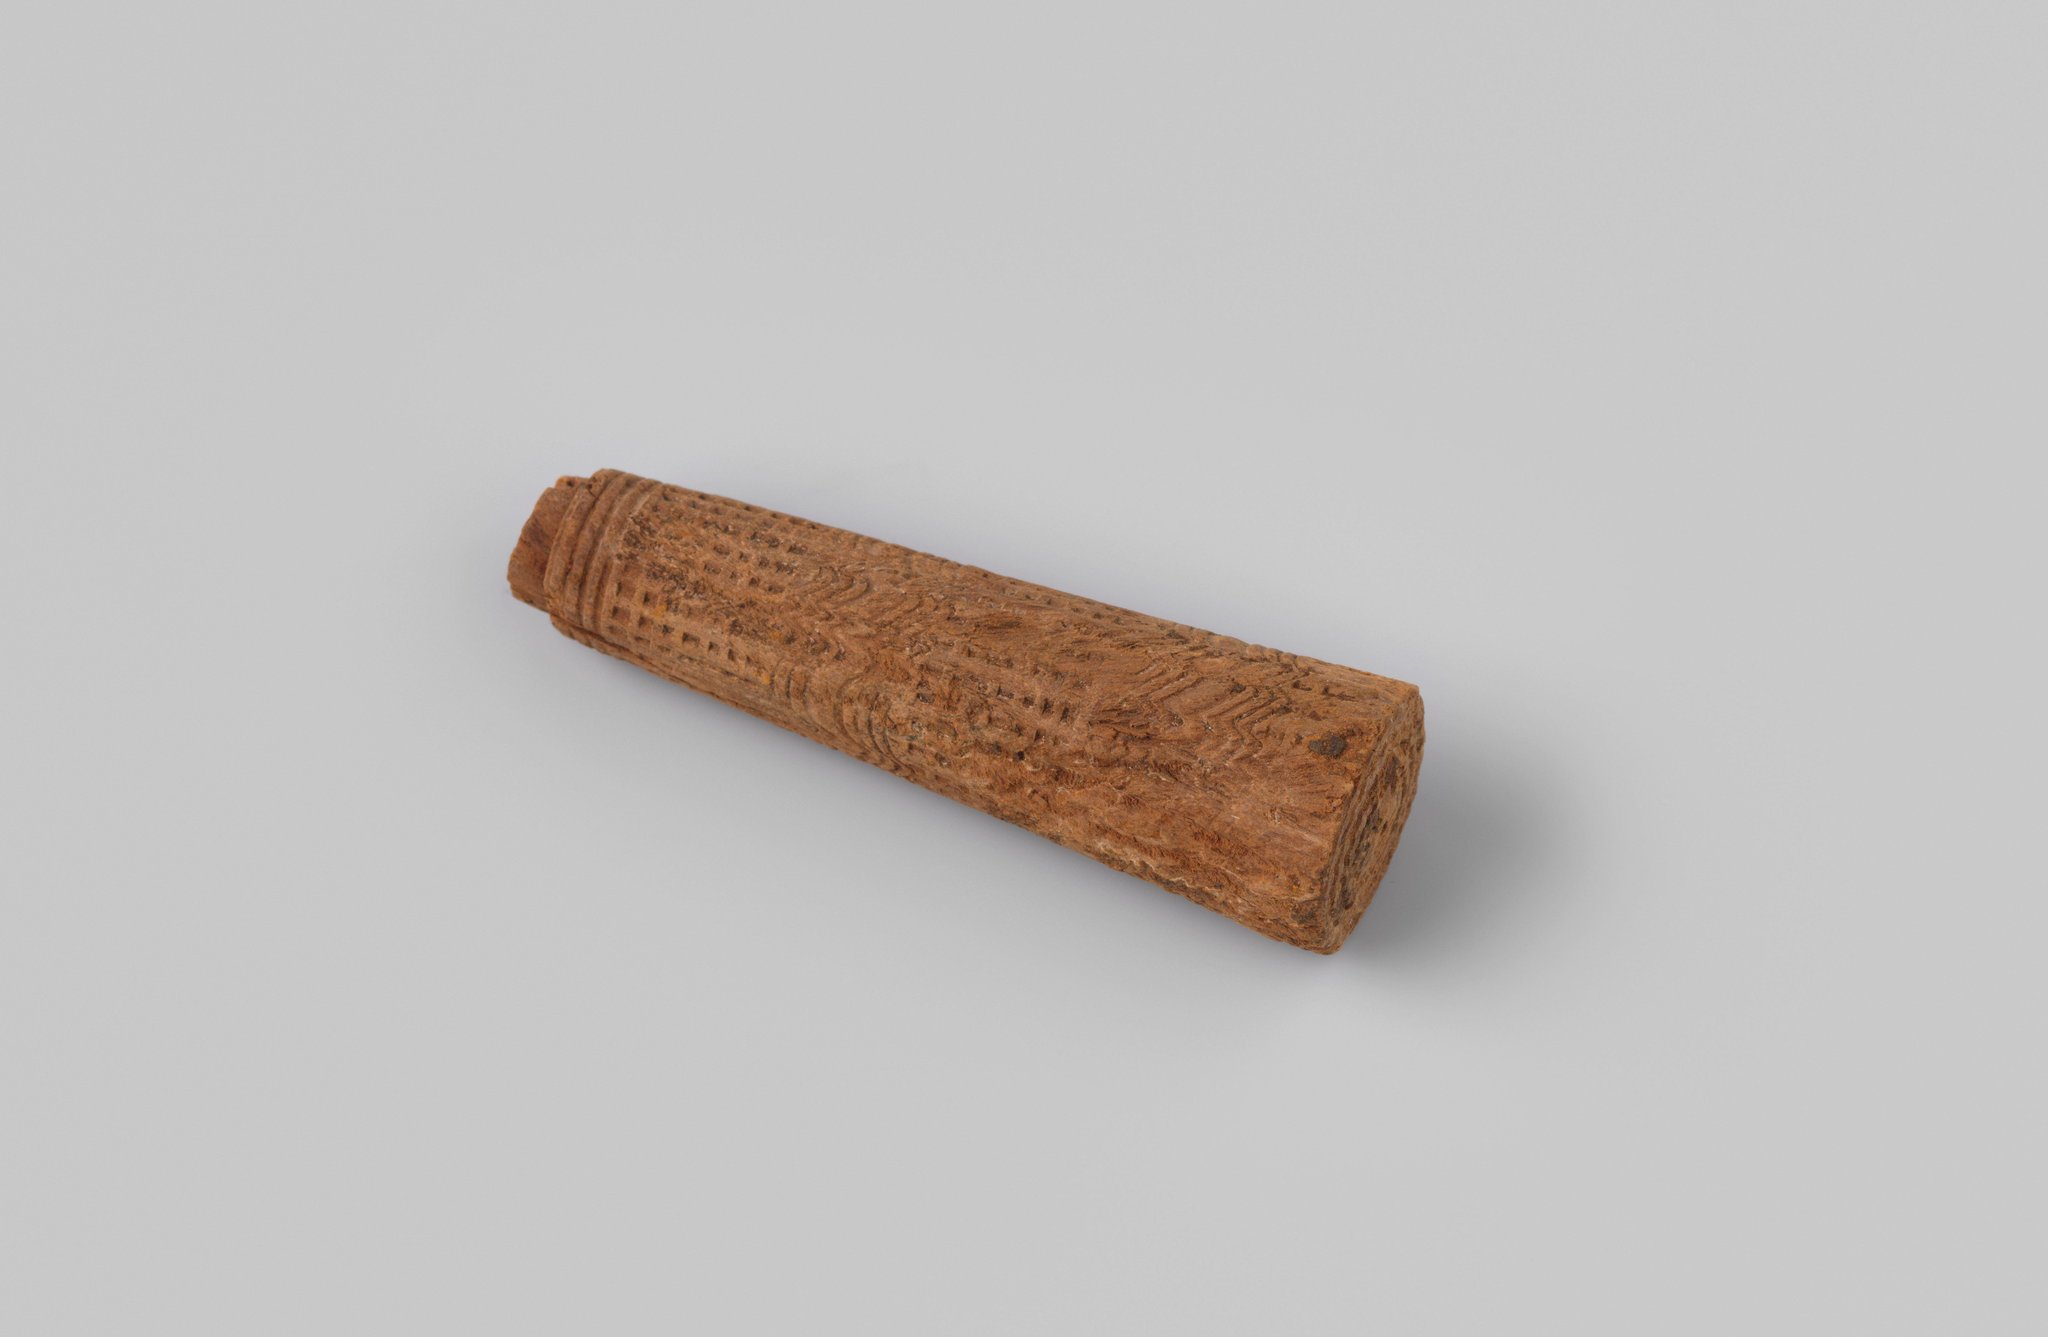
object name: knife handle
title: Messenheft uit het wrak van de Oost-Indiëvaarder Hollandia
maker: Anonymous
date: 1700-1743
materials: wood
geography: netherlands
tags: verenigde oostindische compagnie, hollandia (schip), annet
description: Knife, handle, cylindrical: tapering; id. NG 1979-403H, ferrules id. NG 1980-27H426.